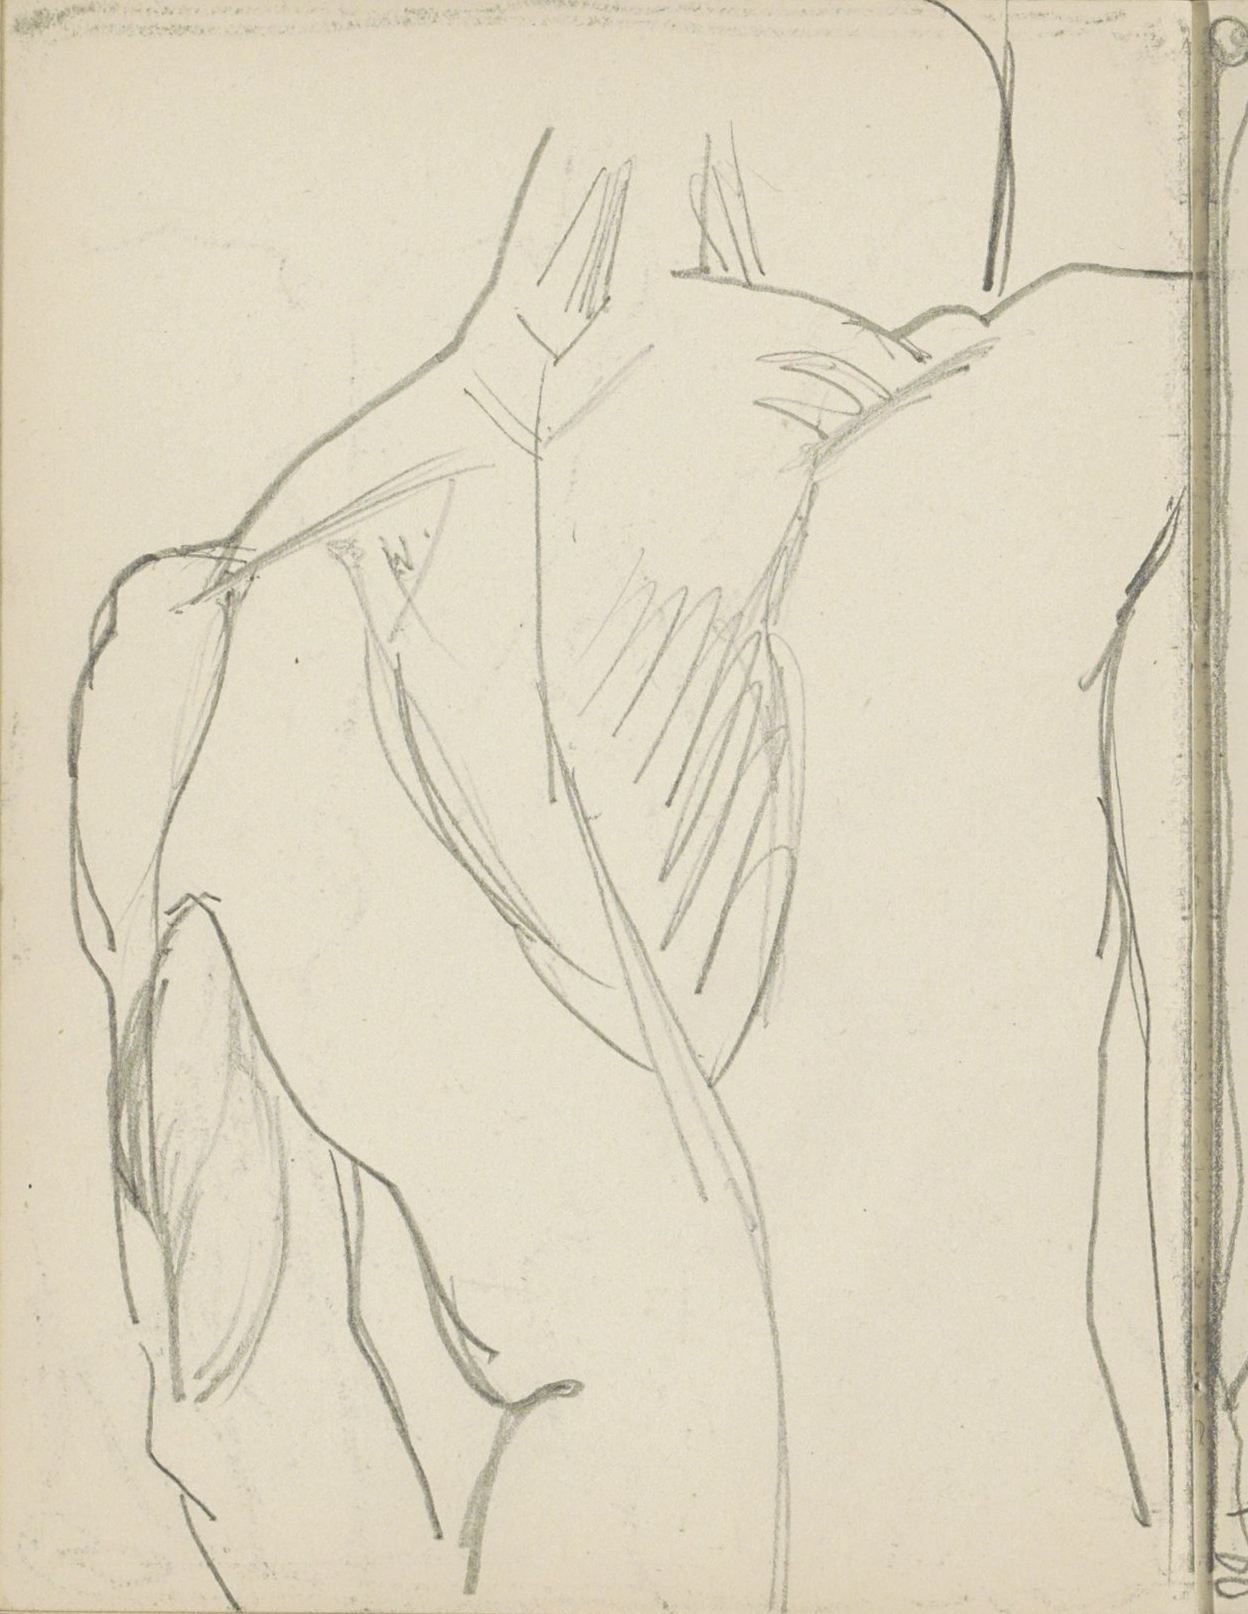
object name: sketchbook leaf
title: Rug van een naakte man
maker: reijer stolk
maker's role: draughtsman, print maker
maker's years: 1896-1945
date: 1906-1945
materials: paper, pencil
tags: back (+ nude human being)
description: Blad 43 verso uit een schetsboek met 69 bladen.